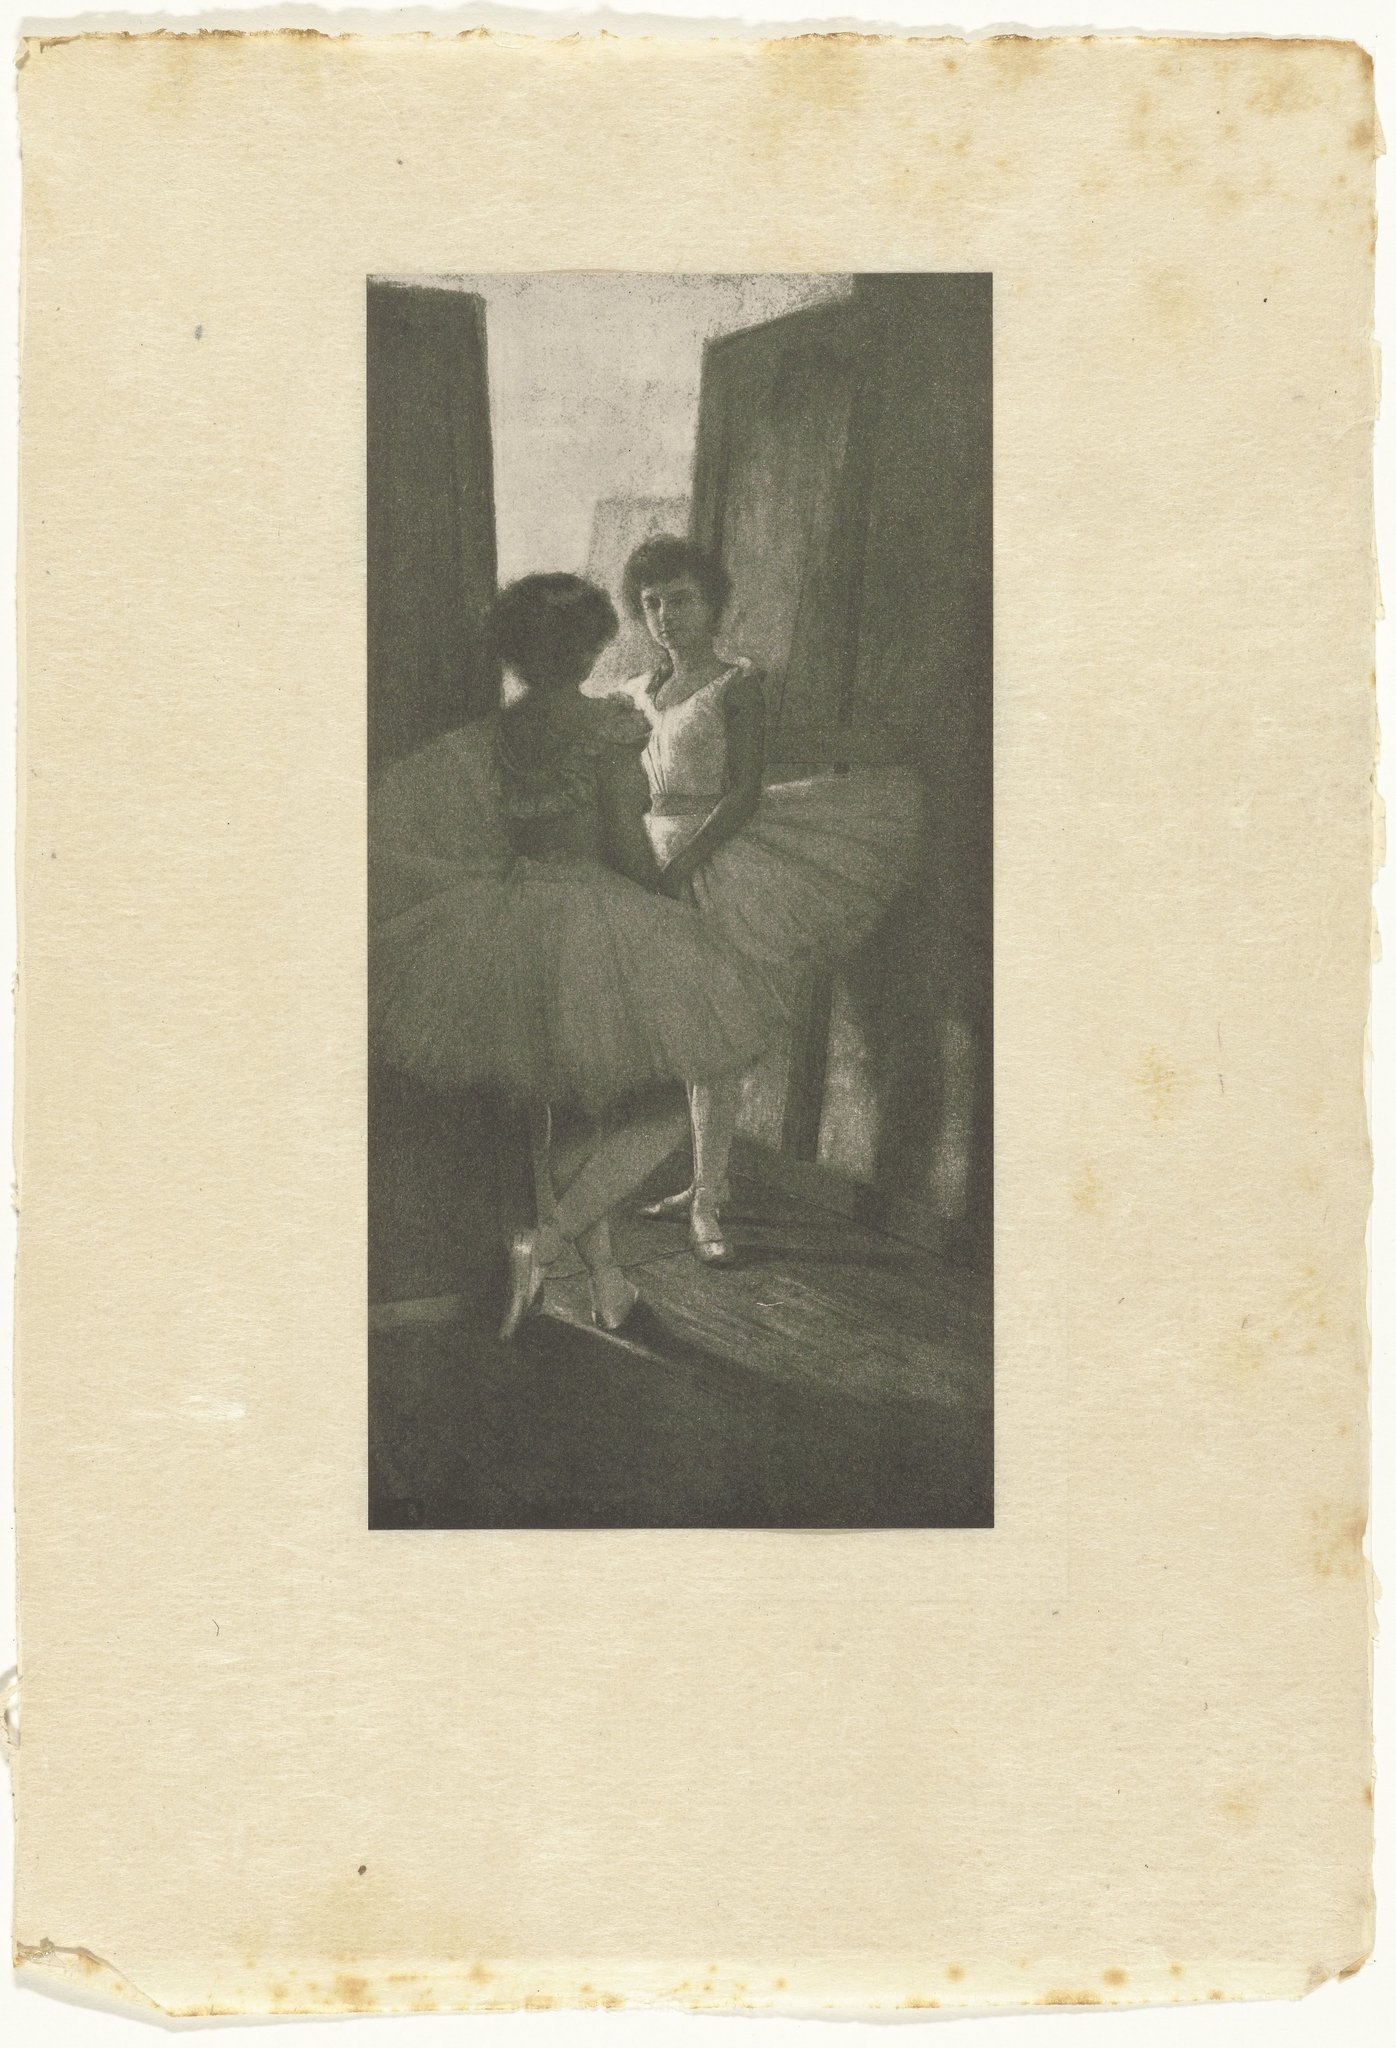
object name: photomechanical print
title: Twee ballerina's achter het decor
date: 1897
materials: paper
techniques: autotype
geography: france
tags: the ballet, ballet performance, girl (child between toddler and youth), france